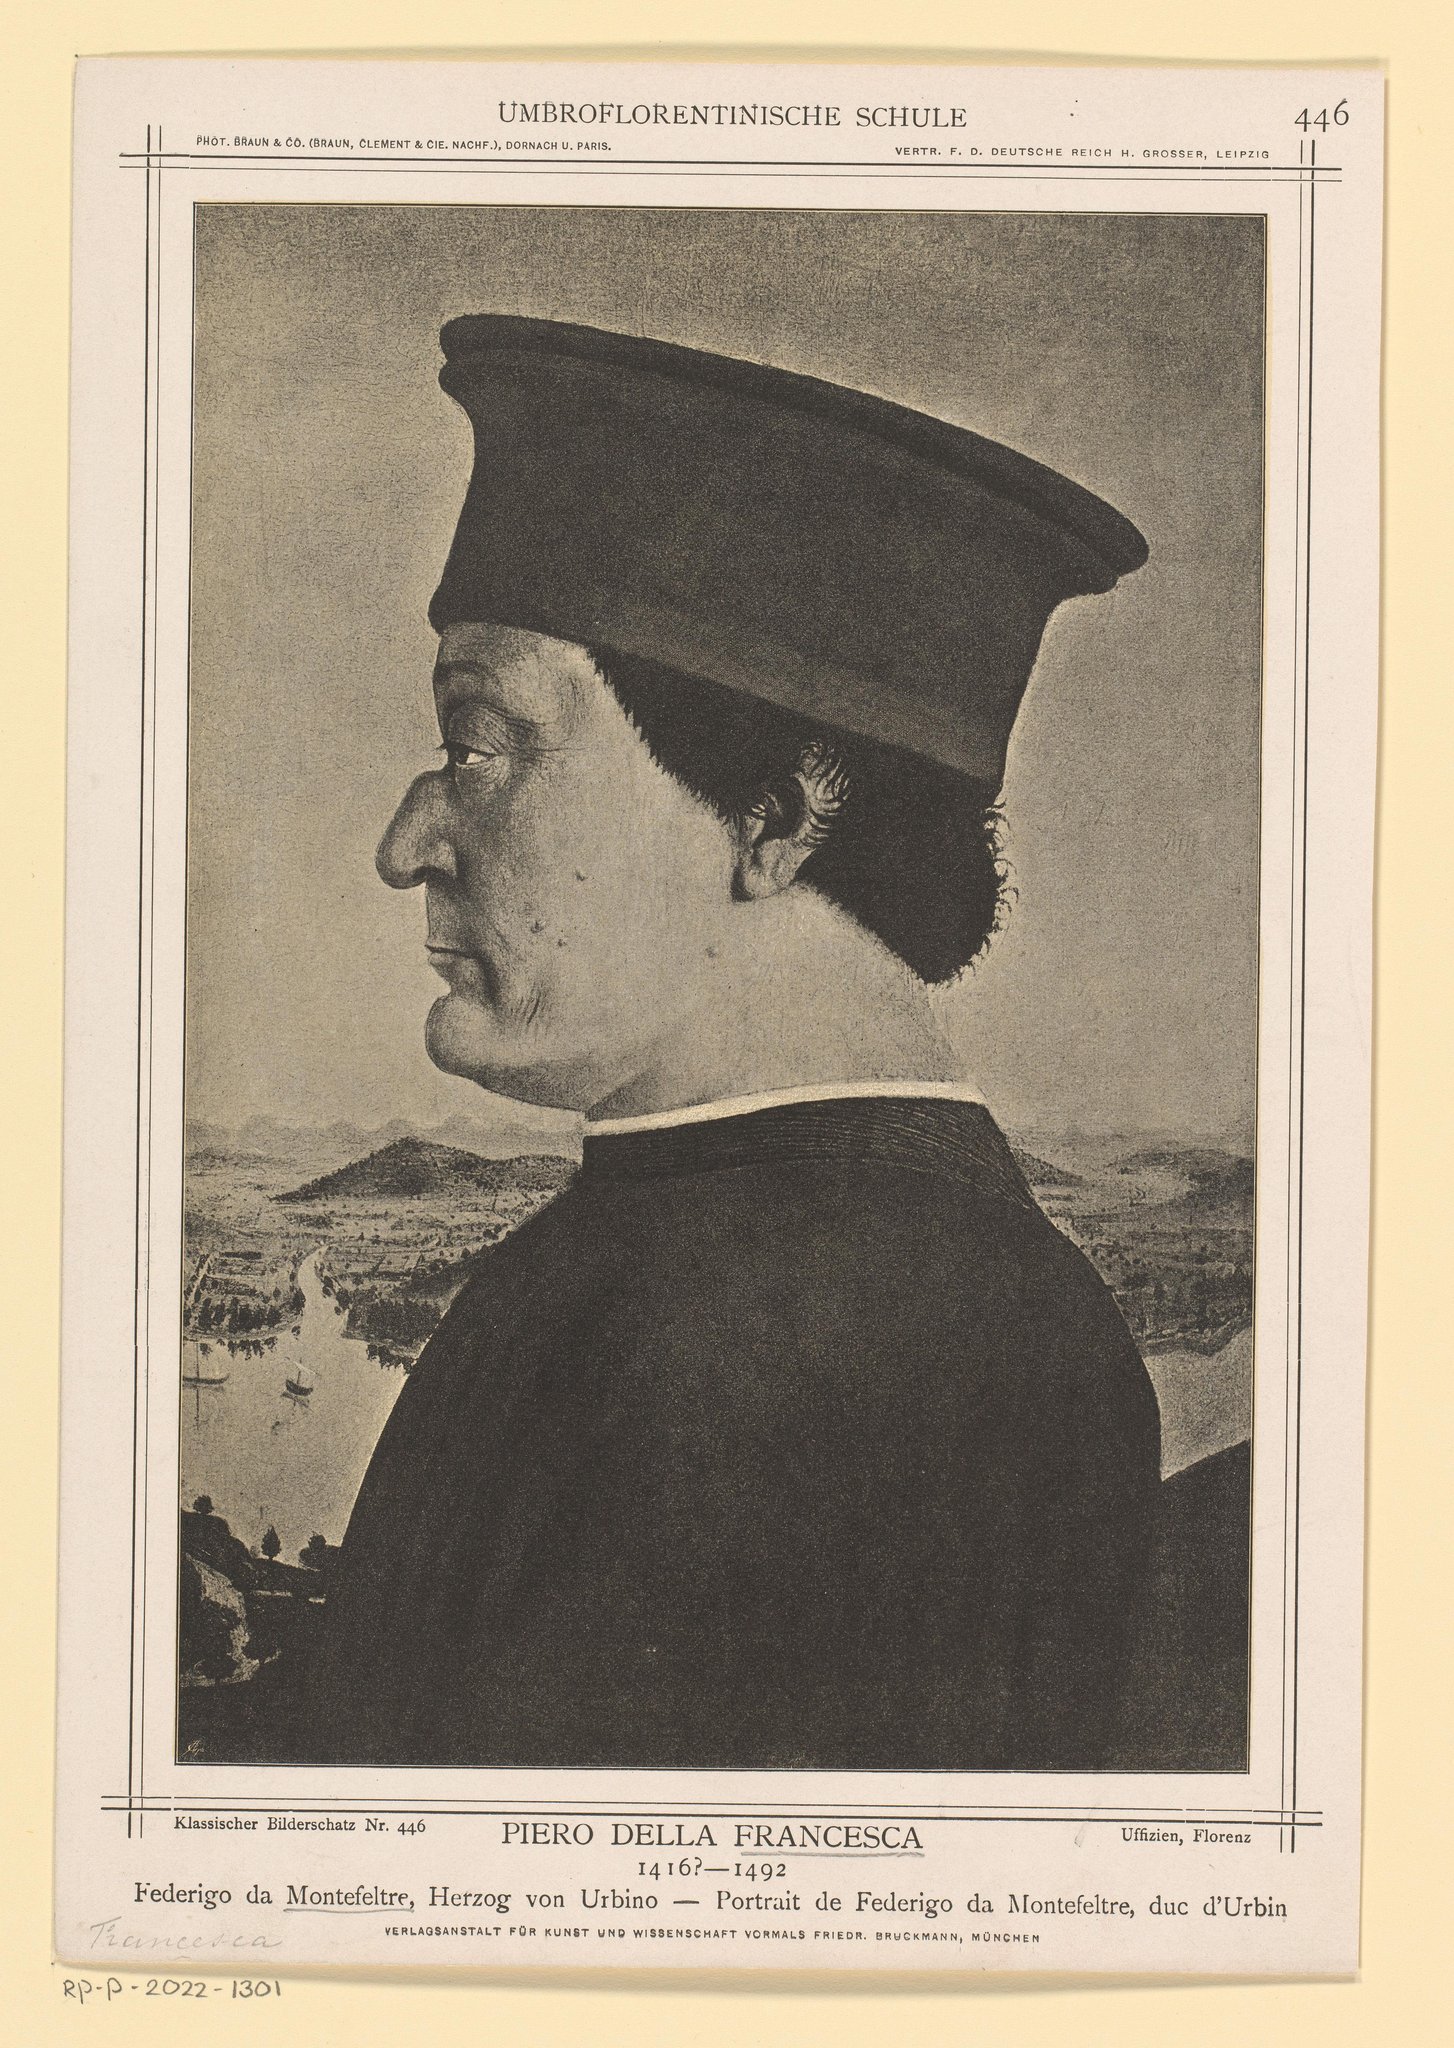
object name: photomechanical print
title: Portret van Federico da Montefeltro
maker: Anonymous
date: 1858-1898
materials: paper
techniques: autotype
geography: munich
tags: commander-in-chief, general, marshal, historical persons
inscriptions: collector's mark: Lugt 2228